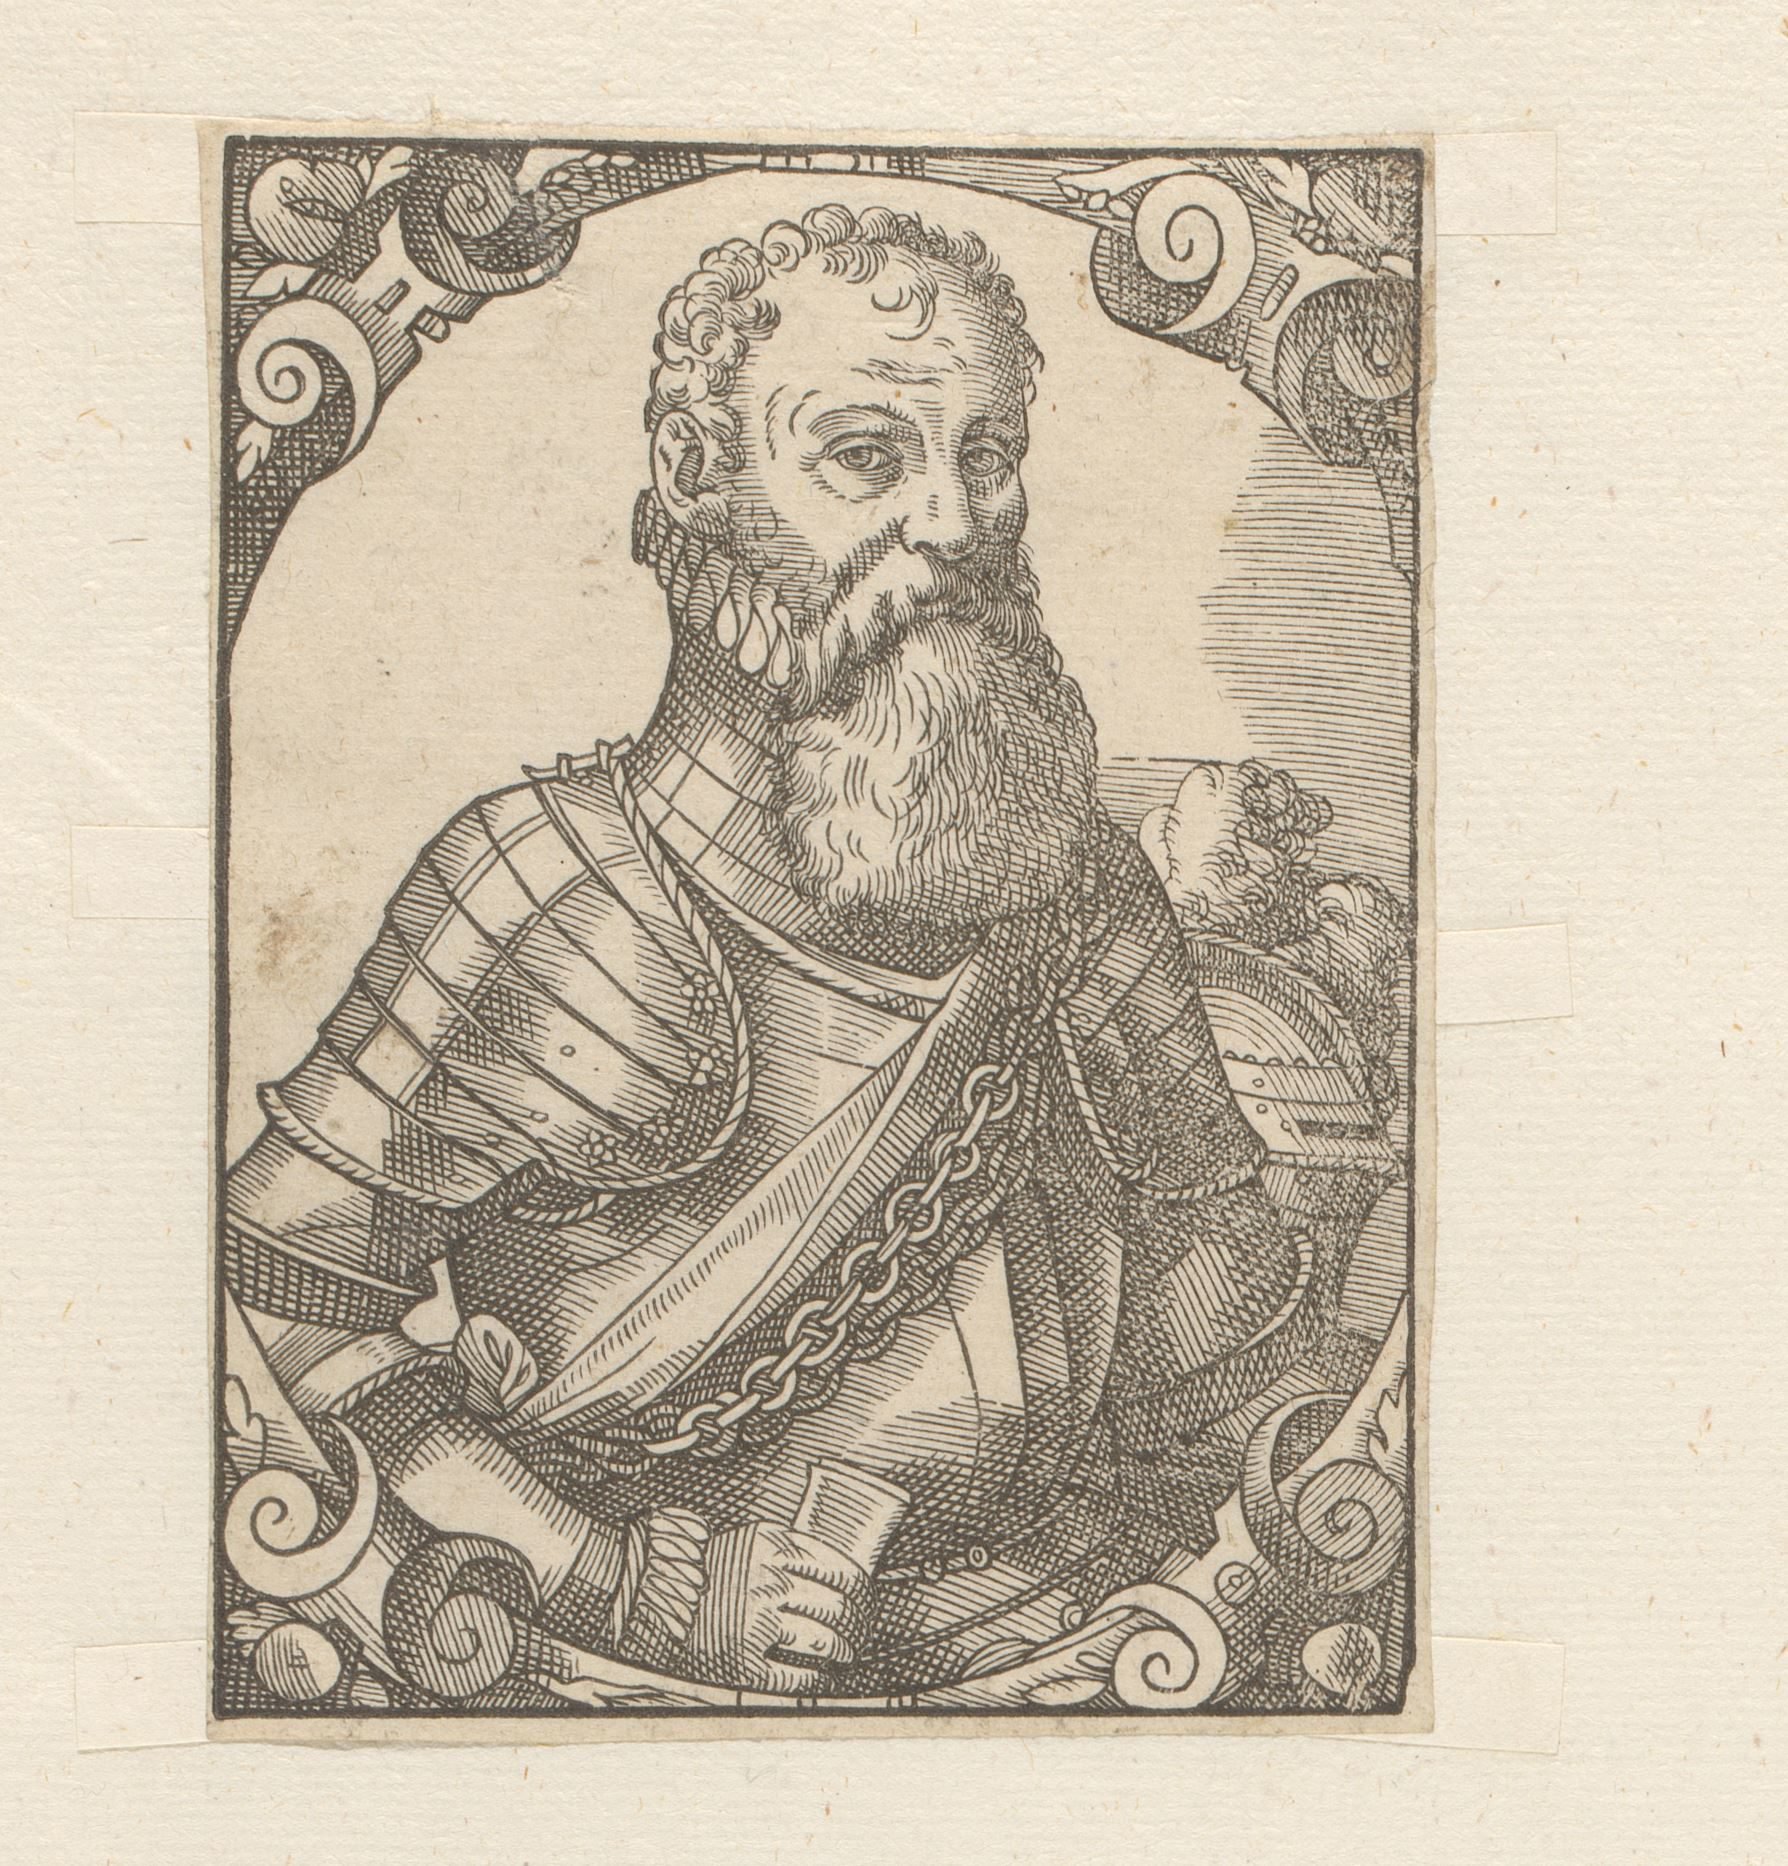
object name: album leaf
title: Portret van Heinrich Rantzau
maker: Anonymous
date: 1549-1582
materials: paper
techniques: woodcut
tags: historical persons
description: Prent gebruikt in: Beuther, Michael. Bildnisse viler zum theyle von uralten, zum theyle von Newlichern zeiten her. Keyser, Könige, Fürsten, Graven und Edlen. Bazel: Peter Perna, 1582.